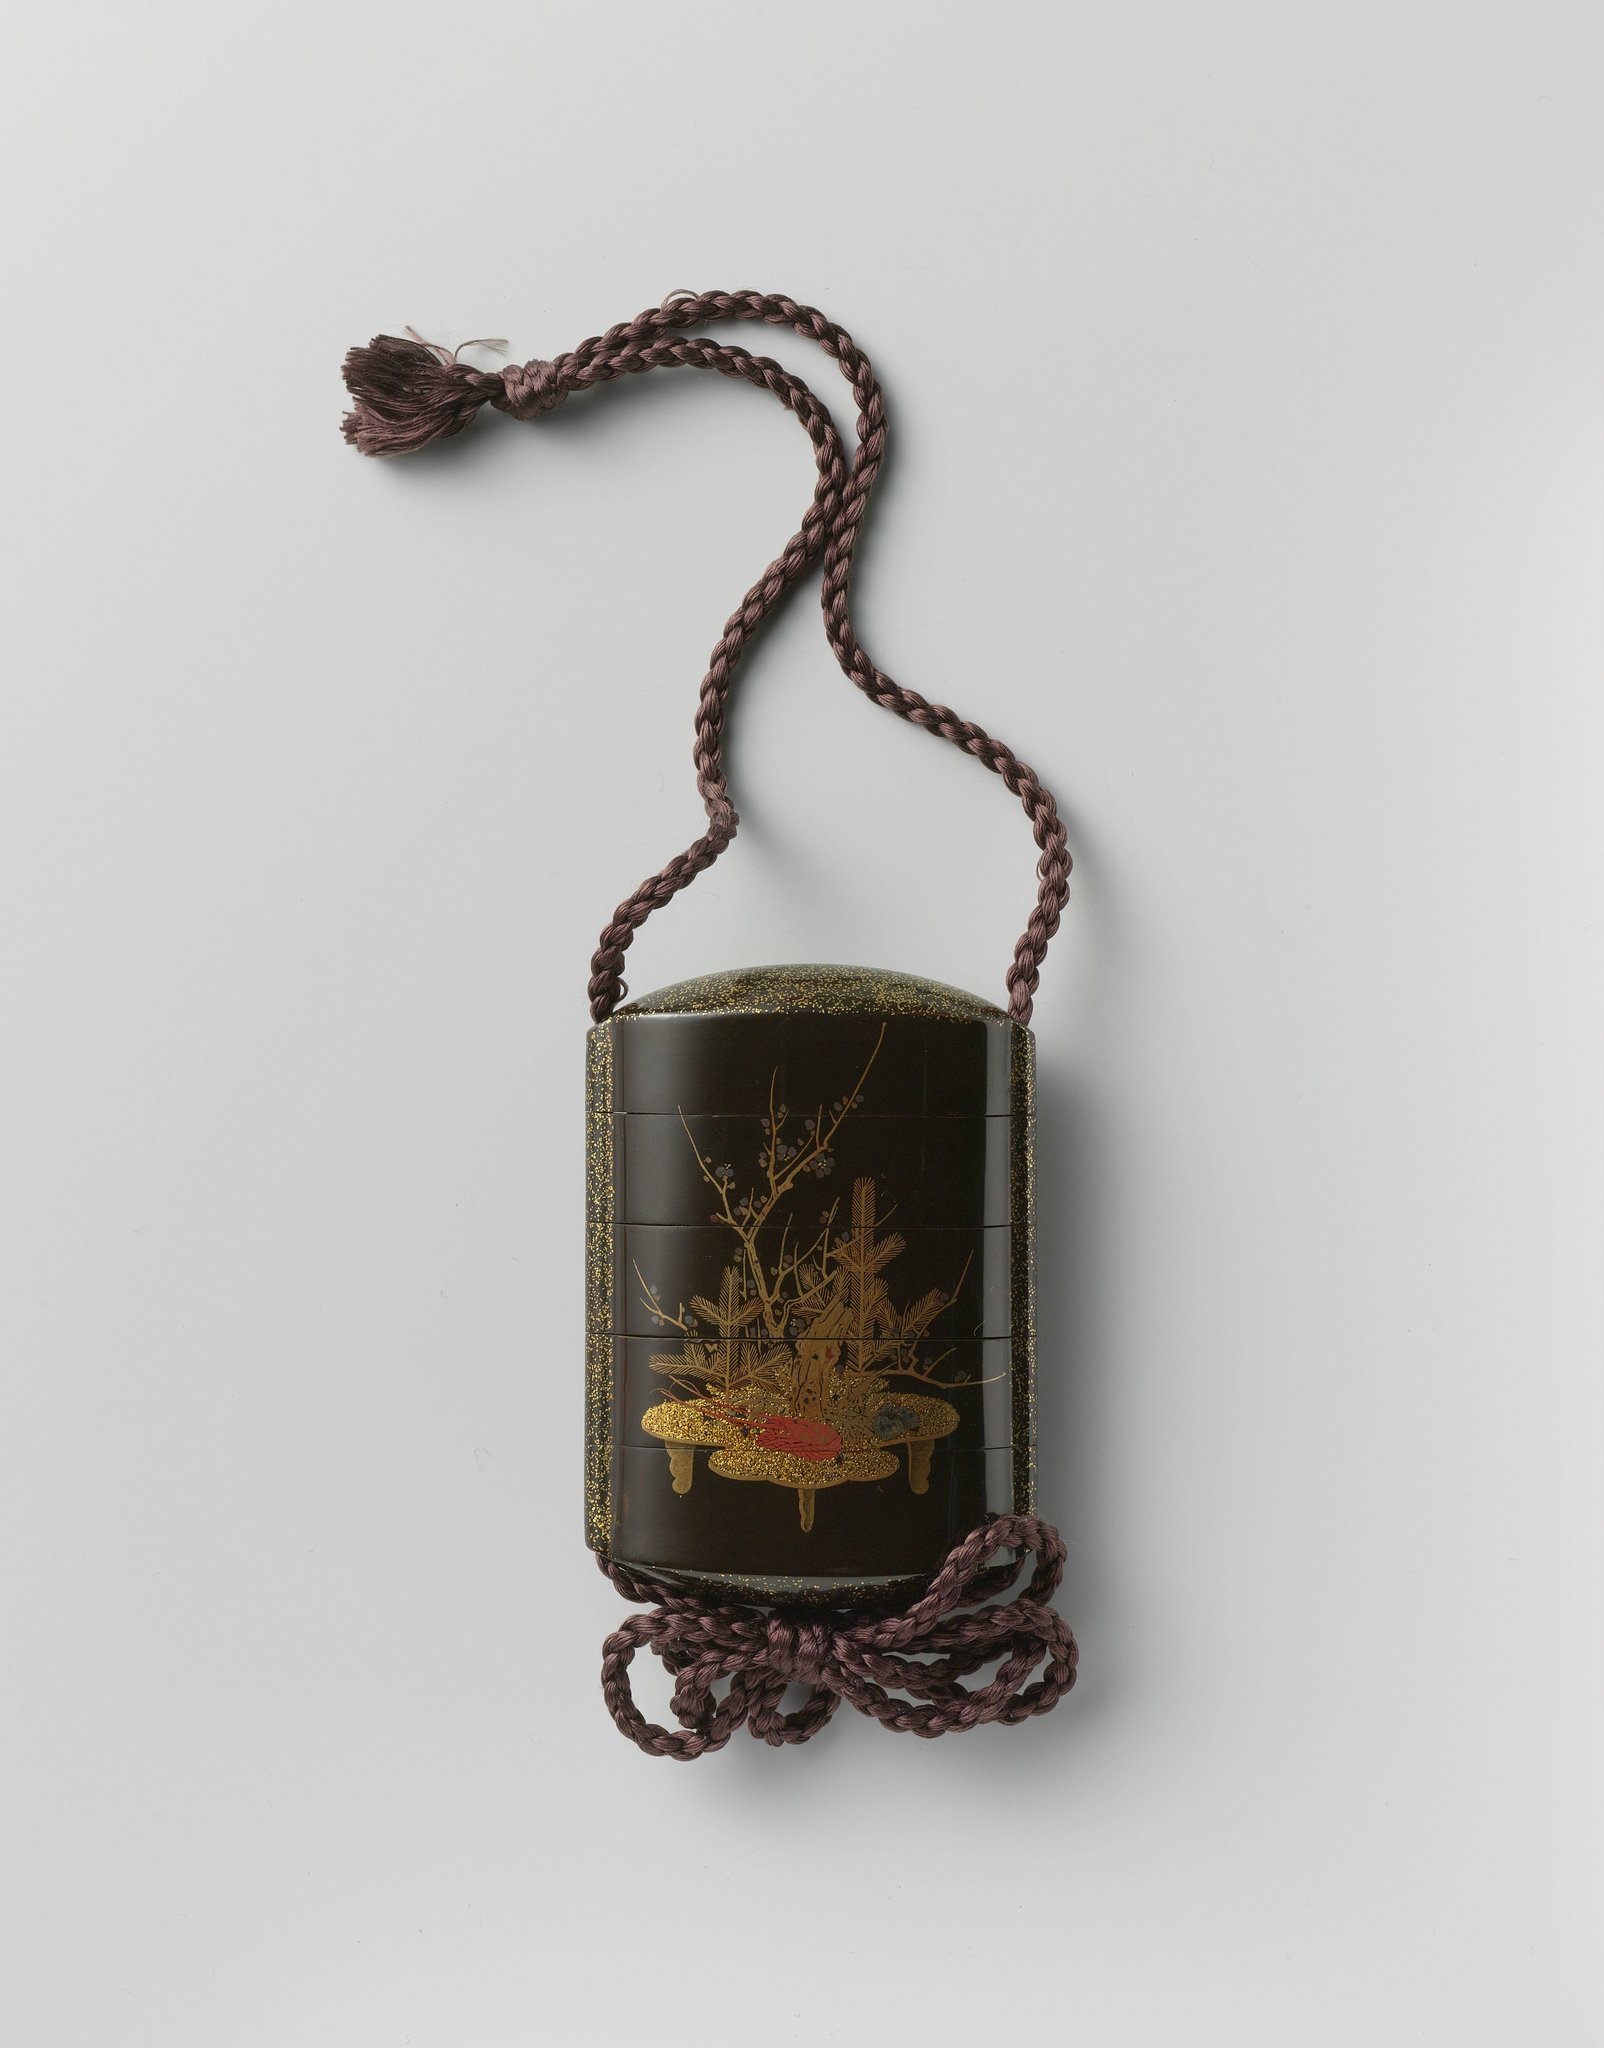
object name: inrō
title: Inro with screen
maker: Anonymous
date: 1800-1825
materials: lacquer, wood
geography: japan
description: Vijfdelige inro met een decoratie van o.a. een kamerscherm en bamboe en aan de andere zijde een bonsai. Gesigneerd.